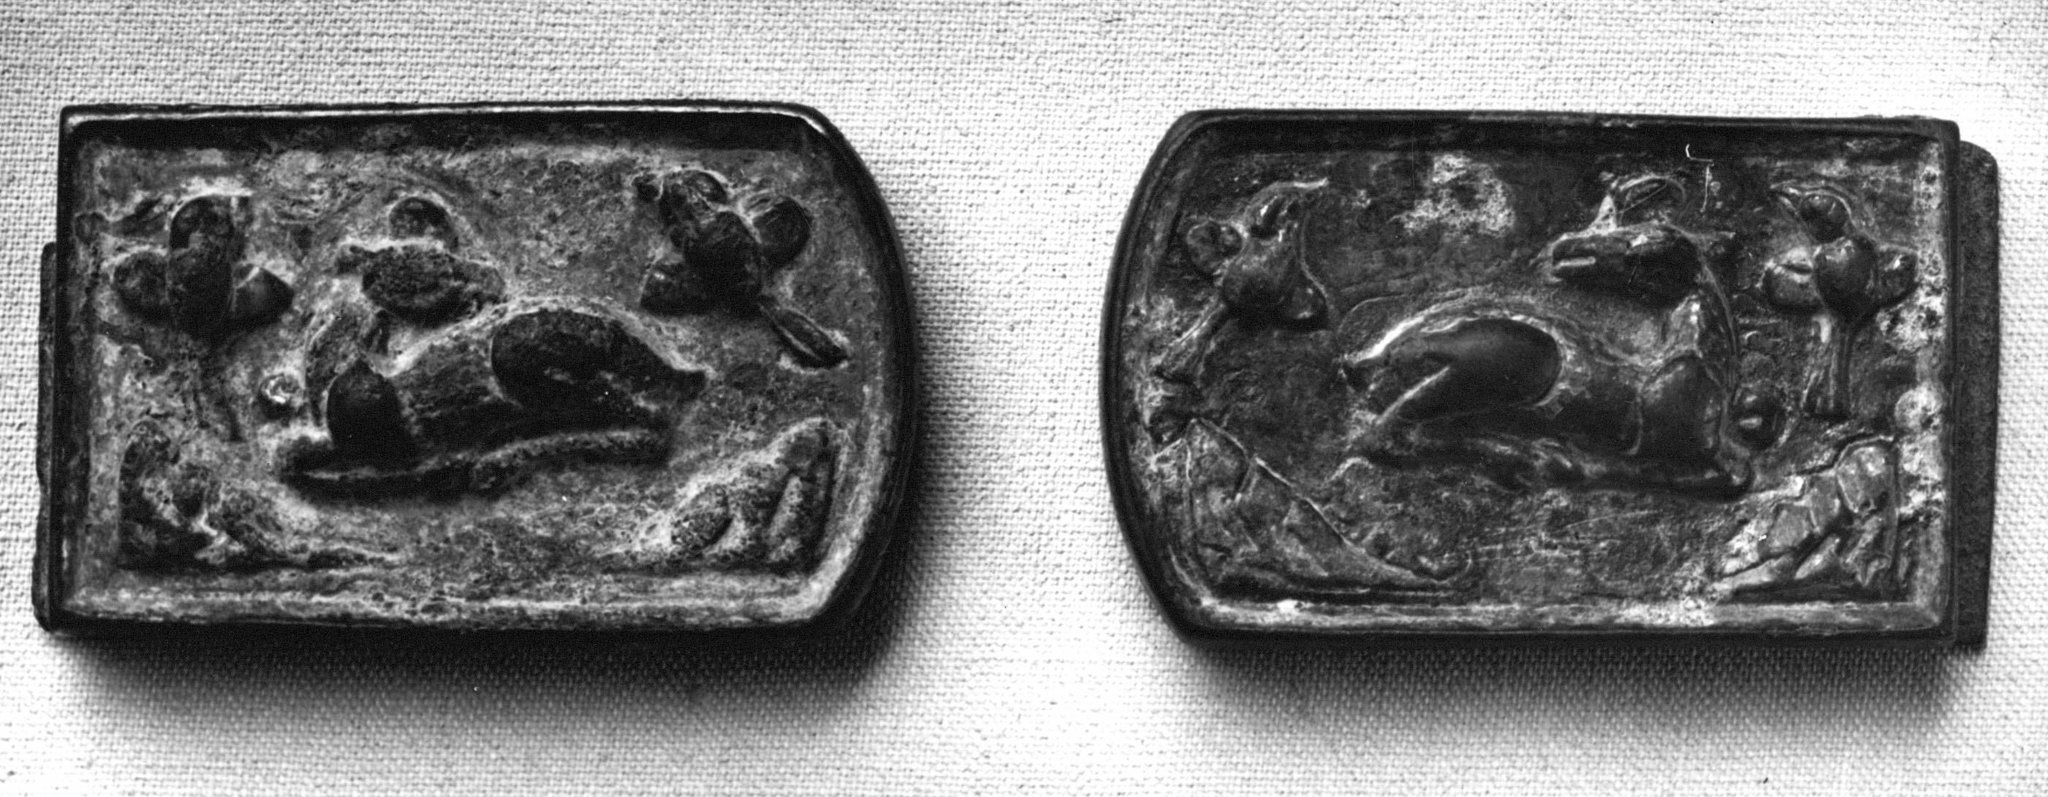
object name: belt plaque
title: Decorative belt plaques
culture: chinese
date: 701-800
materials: gilt bronze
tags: deer